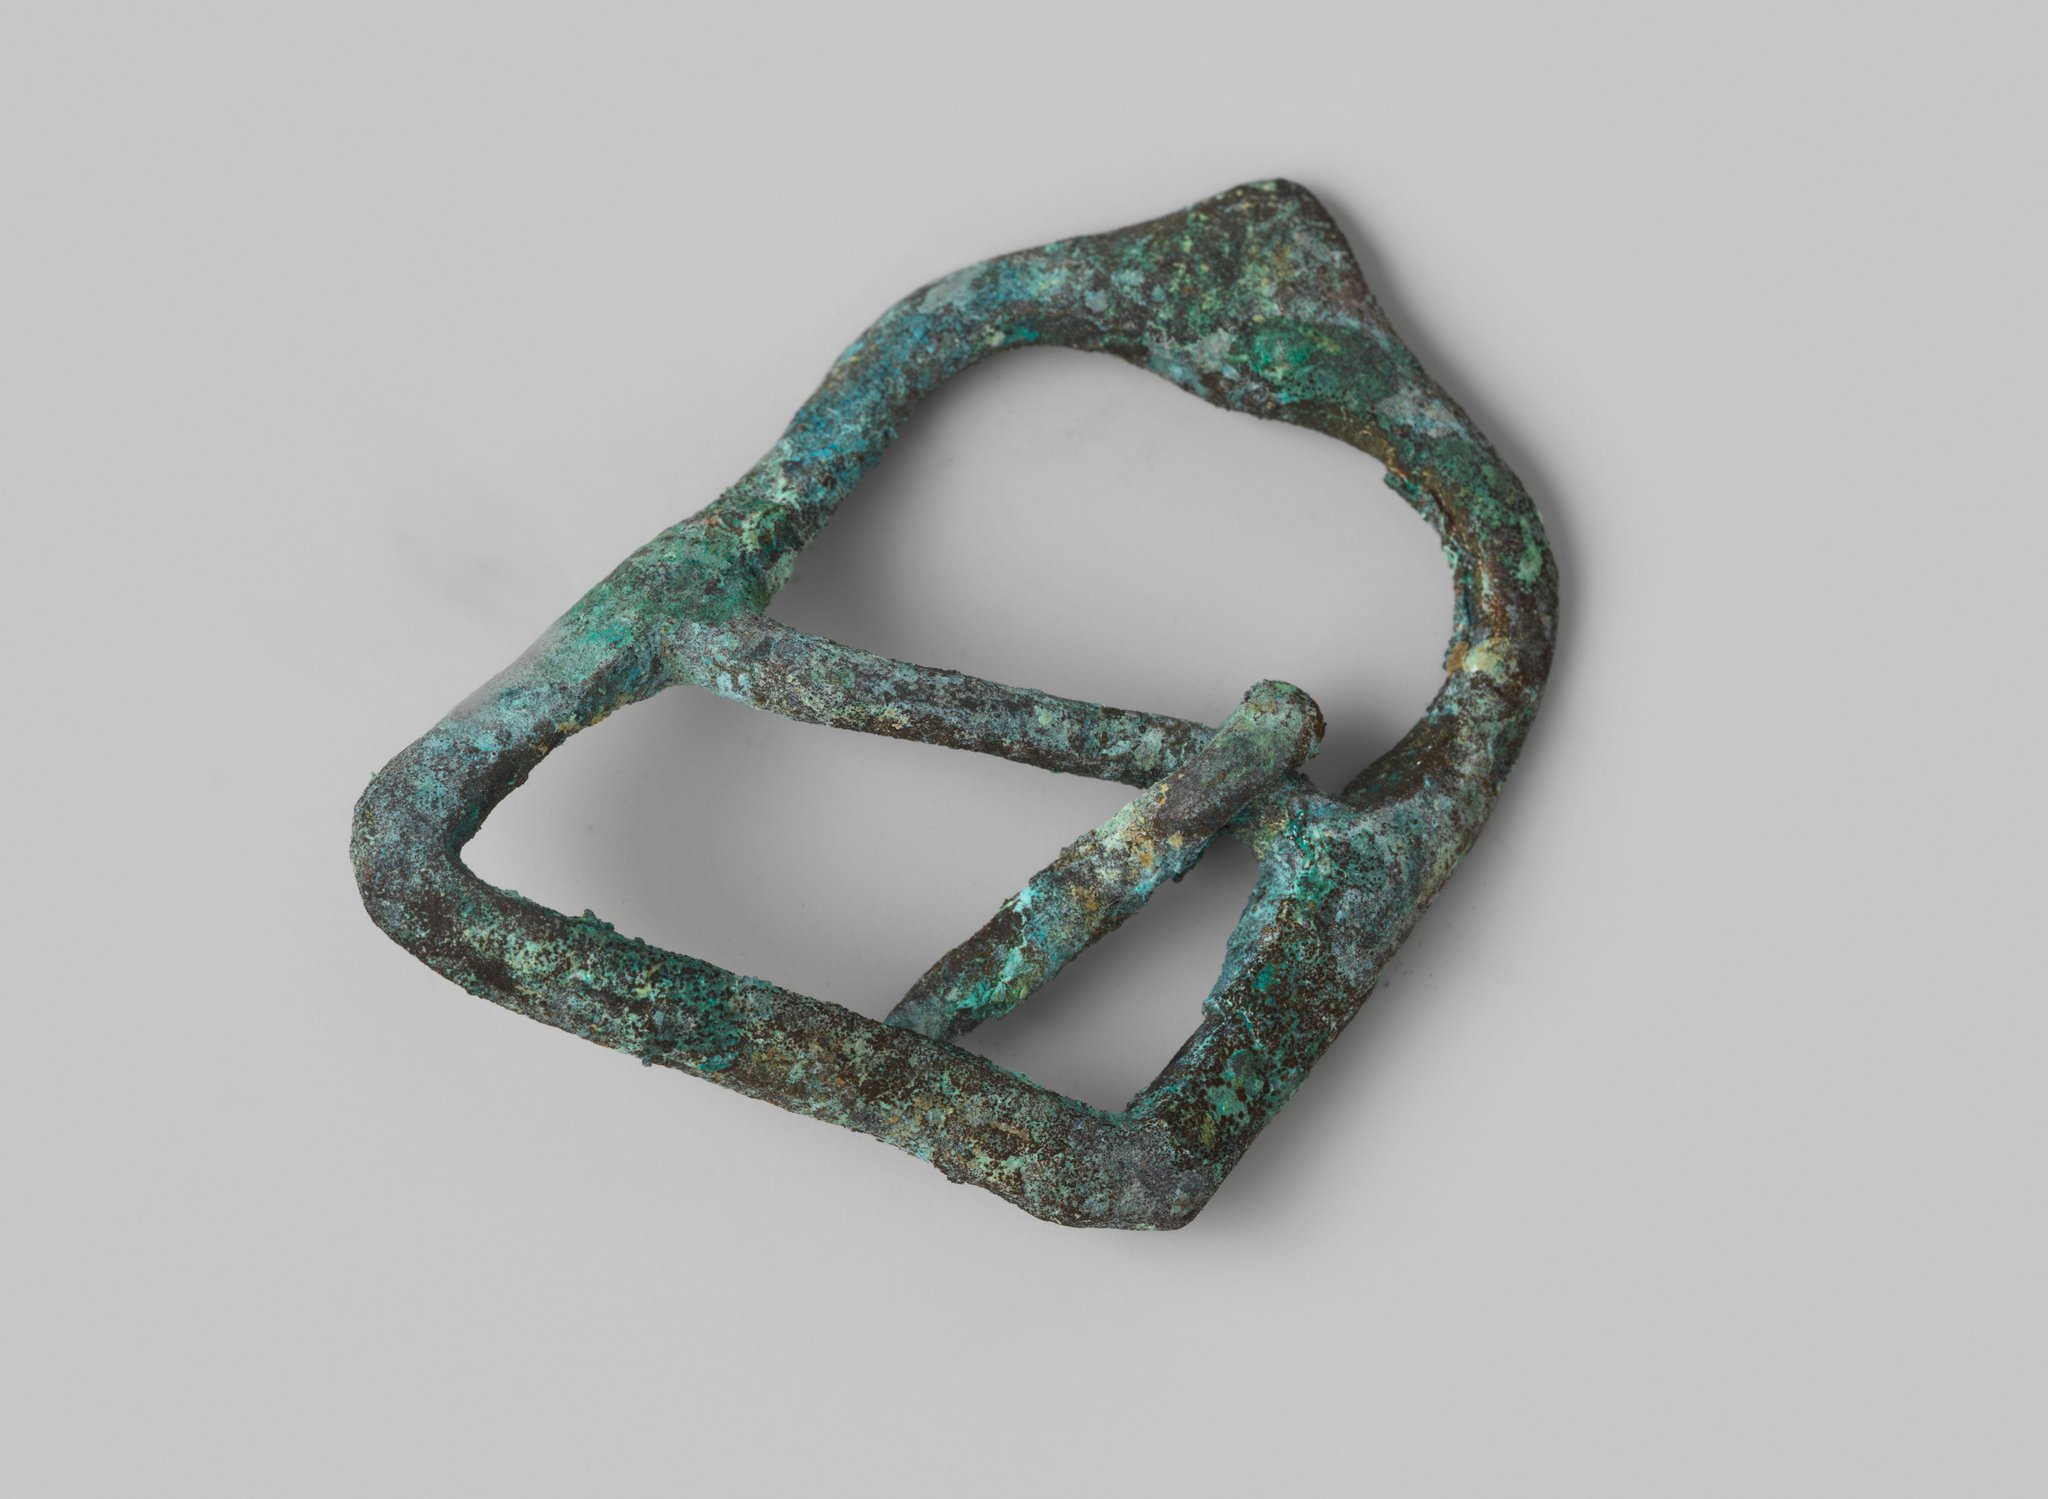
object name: belt buckle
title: Riemgesp uit het wrak van de Oost-Indiëvaarder Hollandia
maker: Anonymous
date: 1700-1743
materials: copper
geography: netherlands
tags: verenigde oostindische compagnie, hollandia (schip), annet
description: D-shaped with pointed side, id. NG 1980-27H384, belt buckle.